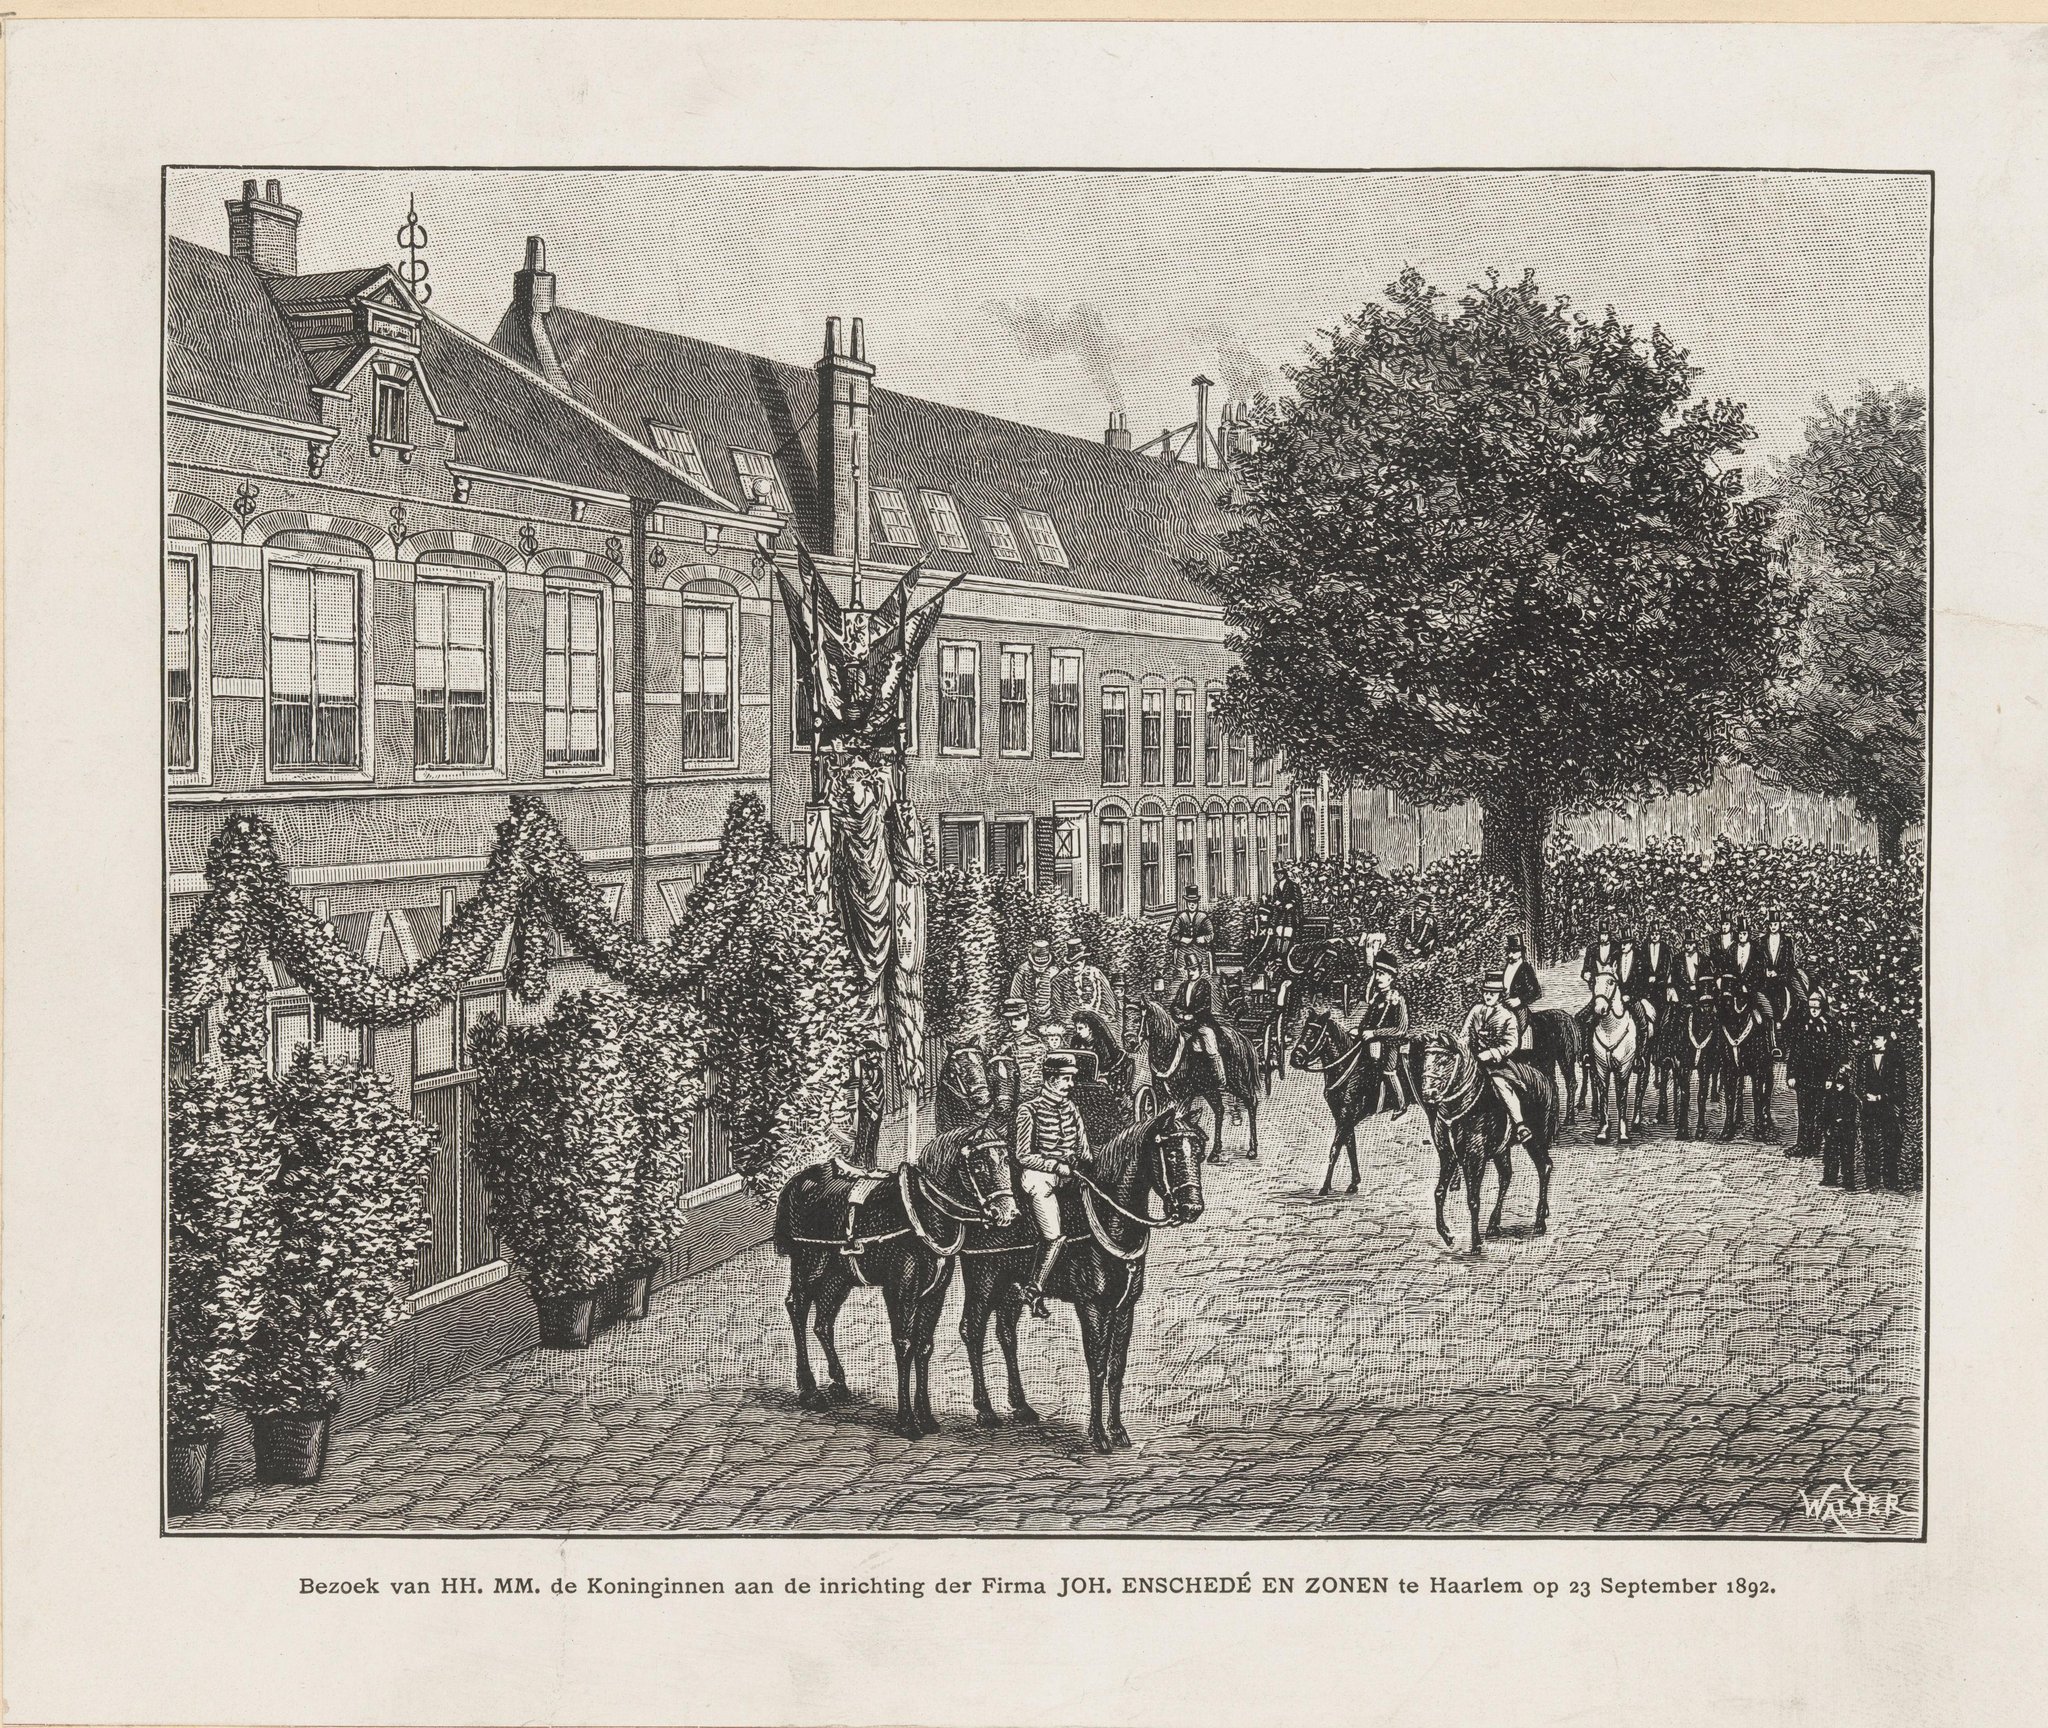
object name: book illustration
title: Bezoek van koningin-regentes Emma en prinses Wilhelmina aan Joh. Enschedé en Zonen in Haarlem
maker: walter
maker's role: draughtsman, print maker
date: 1893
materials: paper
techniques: engraving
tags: print maker, wilhelmina of the netherlands, the hague, emma (queen consort of the netherlands), queen, publishing, publisher, regent, substitute ruler; viceroy, haarlem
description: Prent uit: De lettergieterij van Joh. Enschedé en Zonen: gedenkschrift ter gelegenheid van haar honderdvijftig-jarig bestaan op 9 maart 1893. Haarlem: Joh. Enschedé en Zonen, 1893.